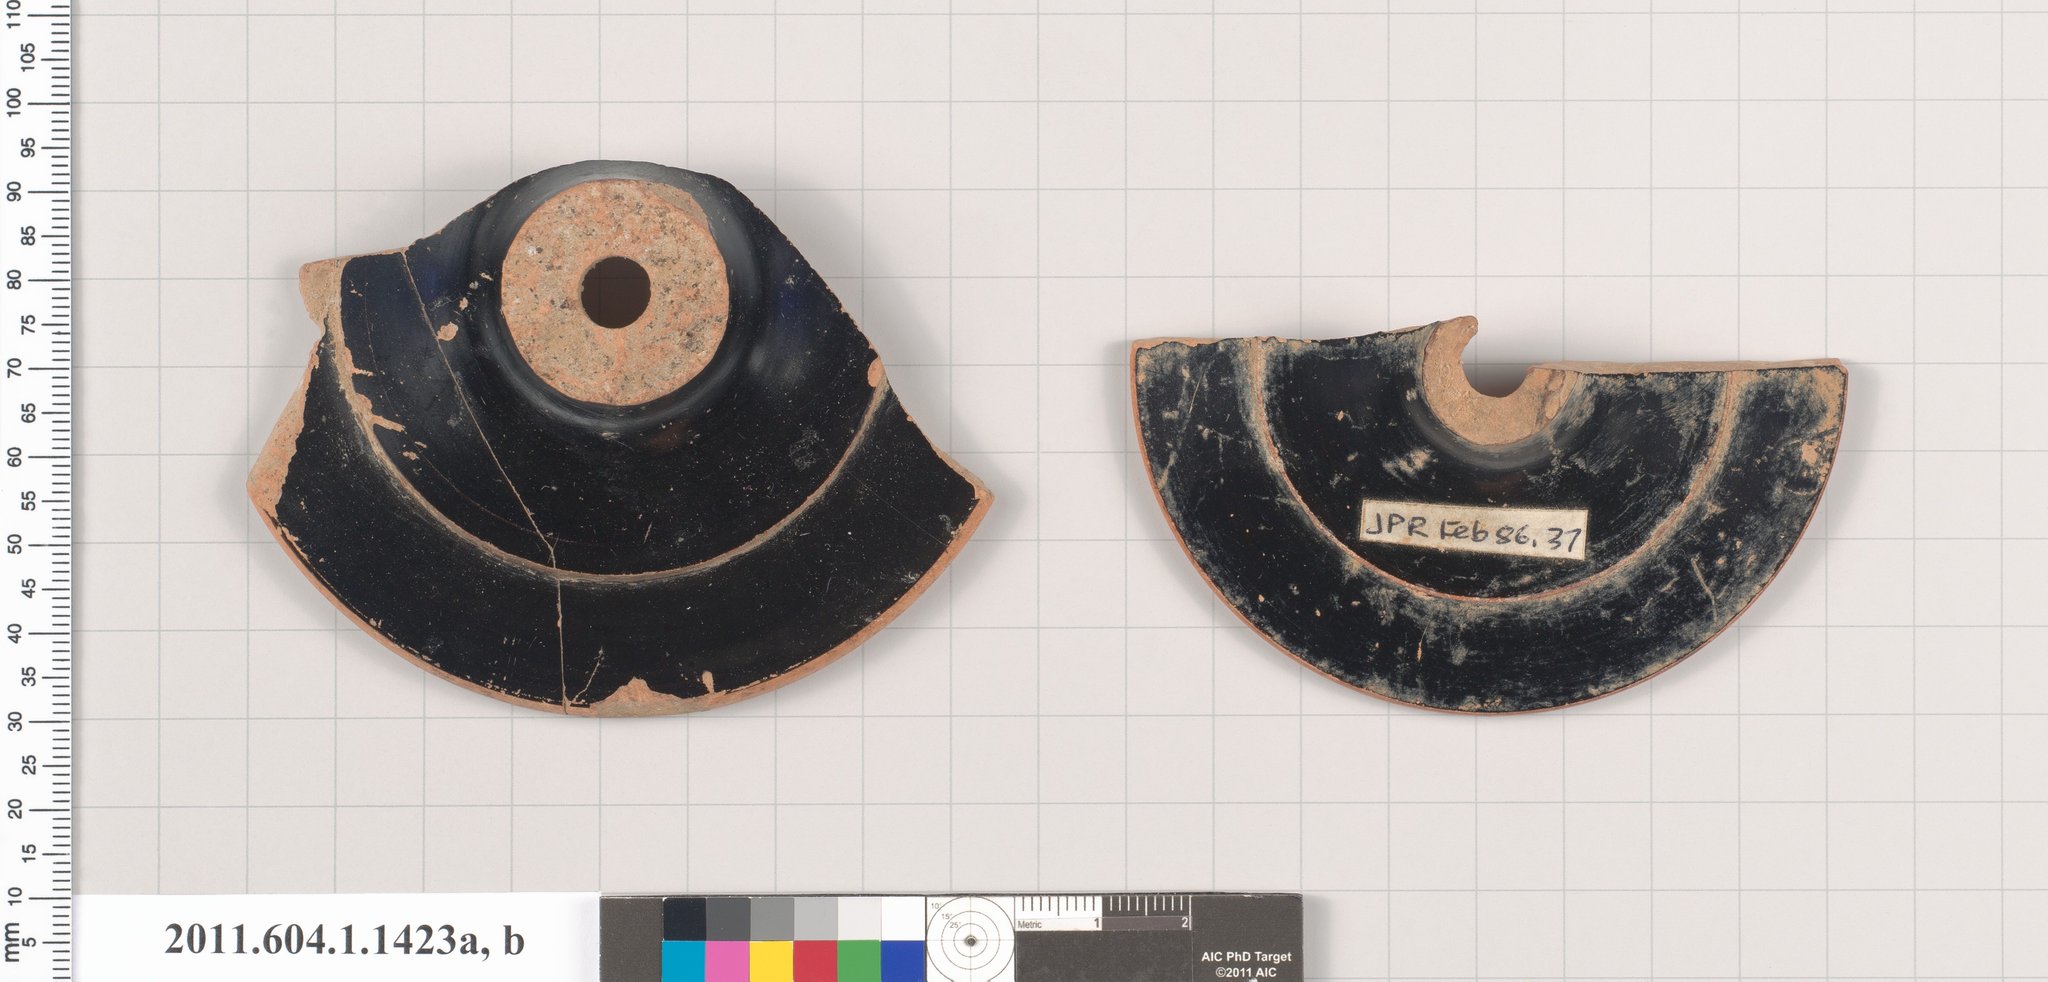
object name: kylix fragment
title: Terracotta fragments of kylikes (drinking cups)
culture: greek, attic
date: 500-401 BCE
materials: terracotta